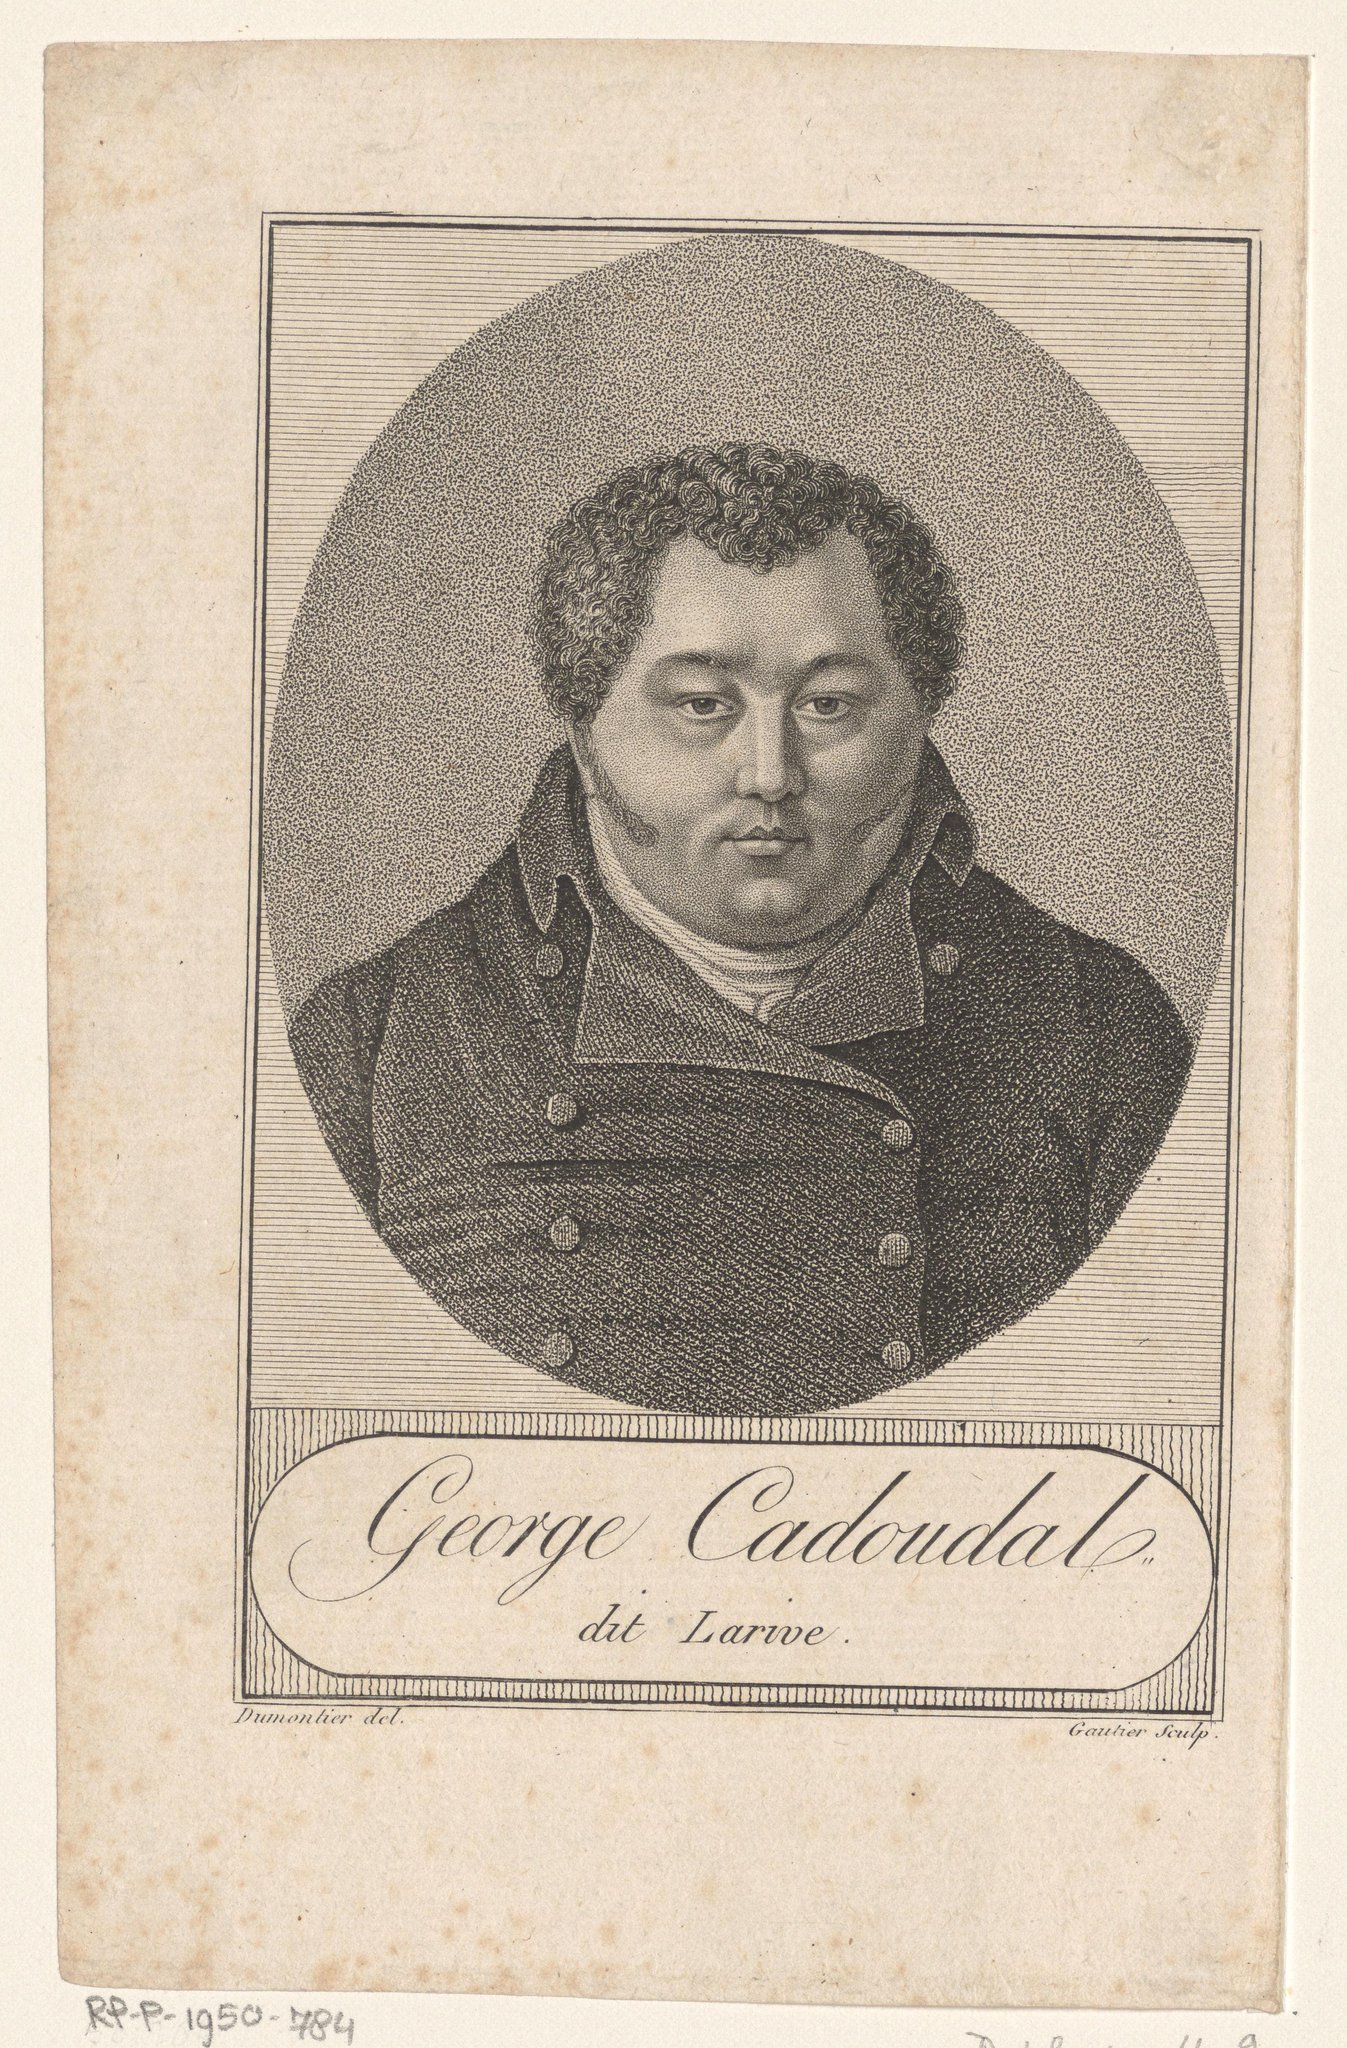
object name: print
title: Portret van George Cadoudale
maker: jean-baptiste gautier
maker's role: print maker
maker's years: 1775-1825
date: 1804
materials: paper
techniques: etching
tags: historical persons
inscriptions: collector's mark: Lugt 2228